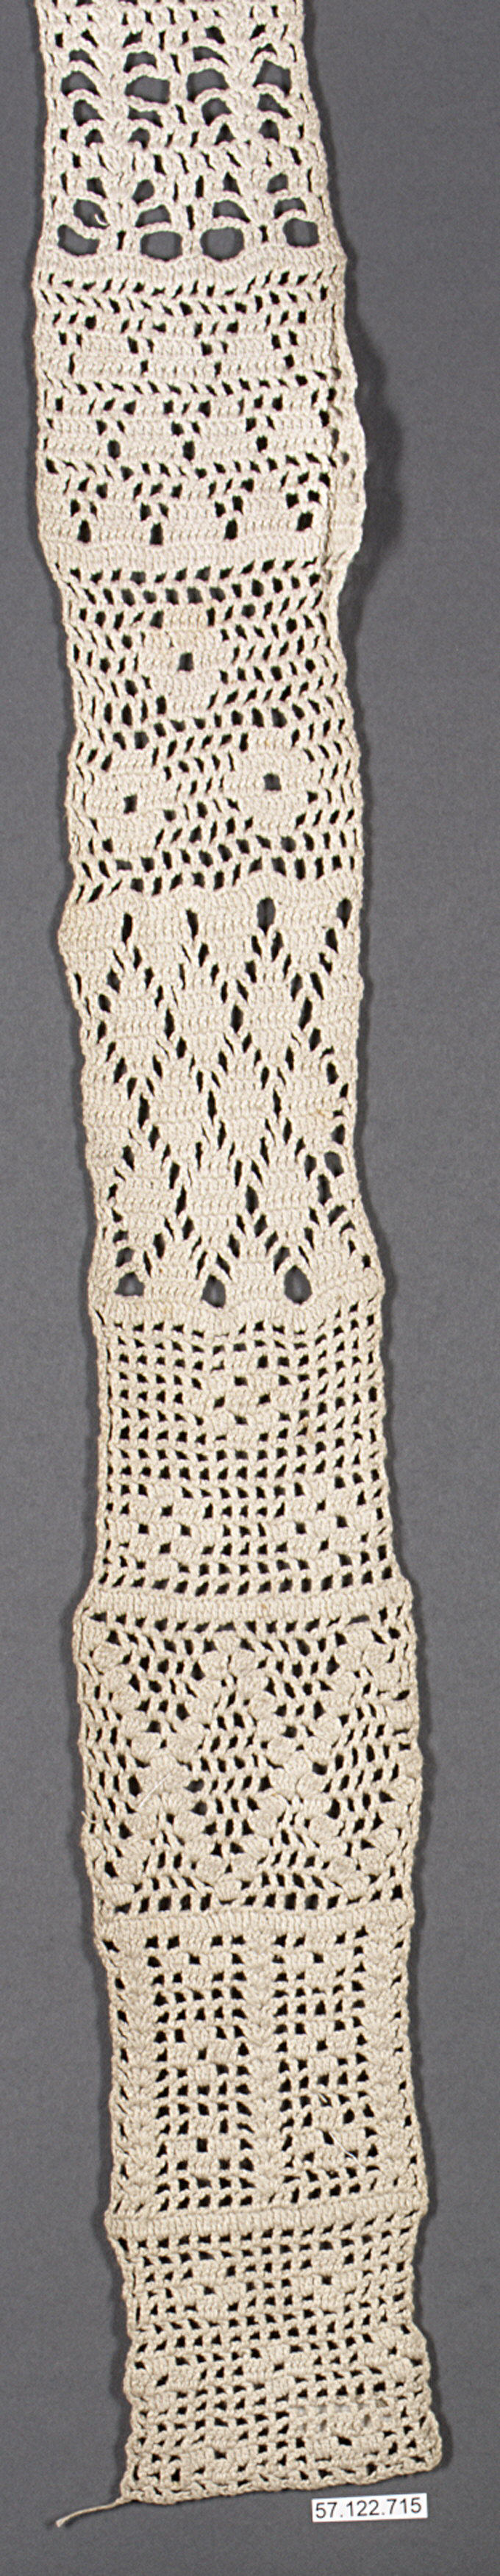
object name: sampler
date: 1801-1900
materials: cotton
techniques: crochet